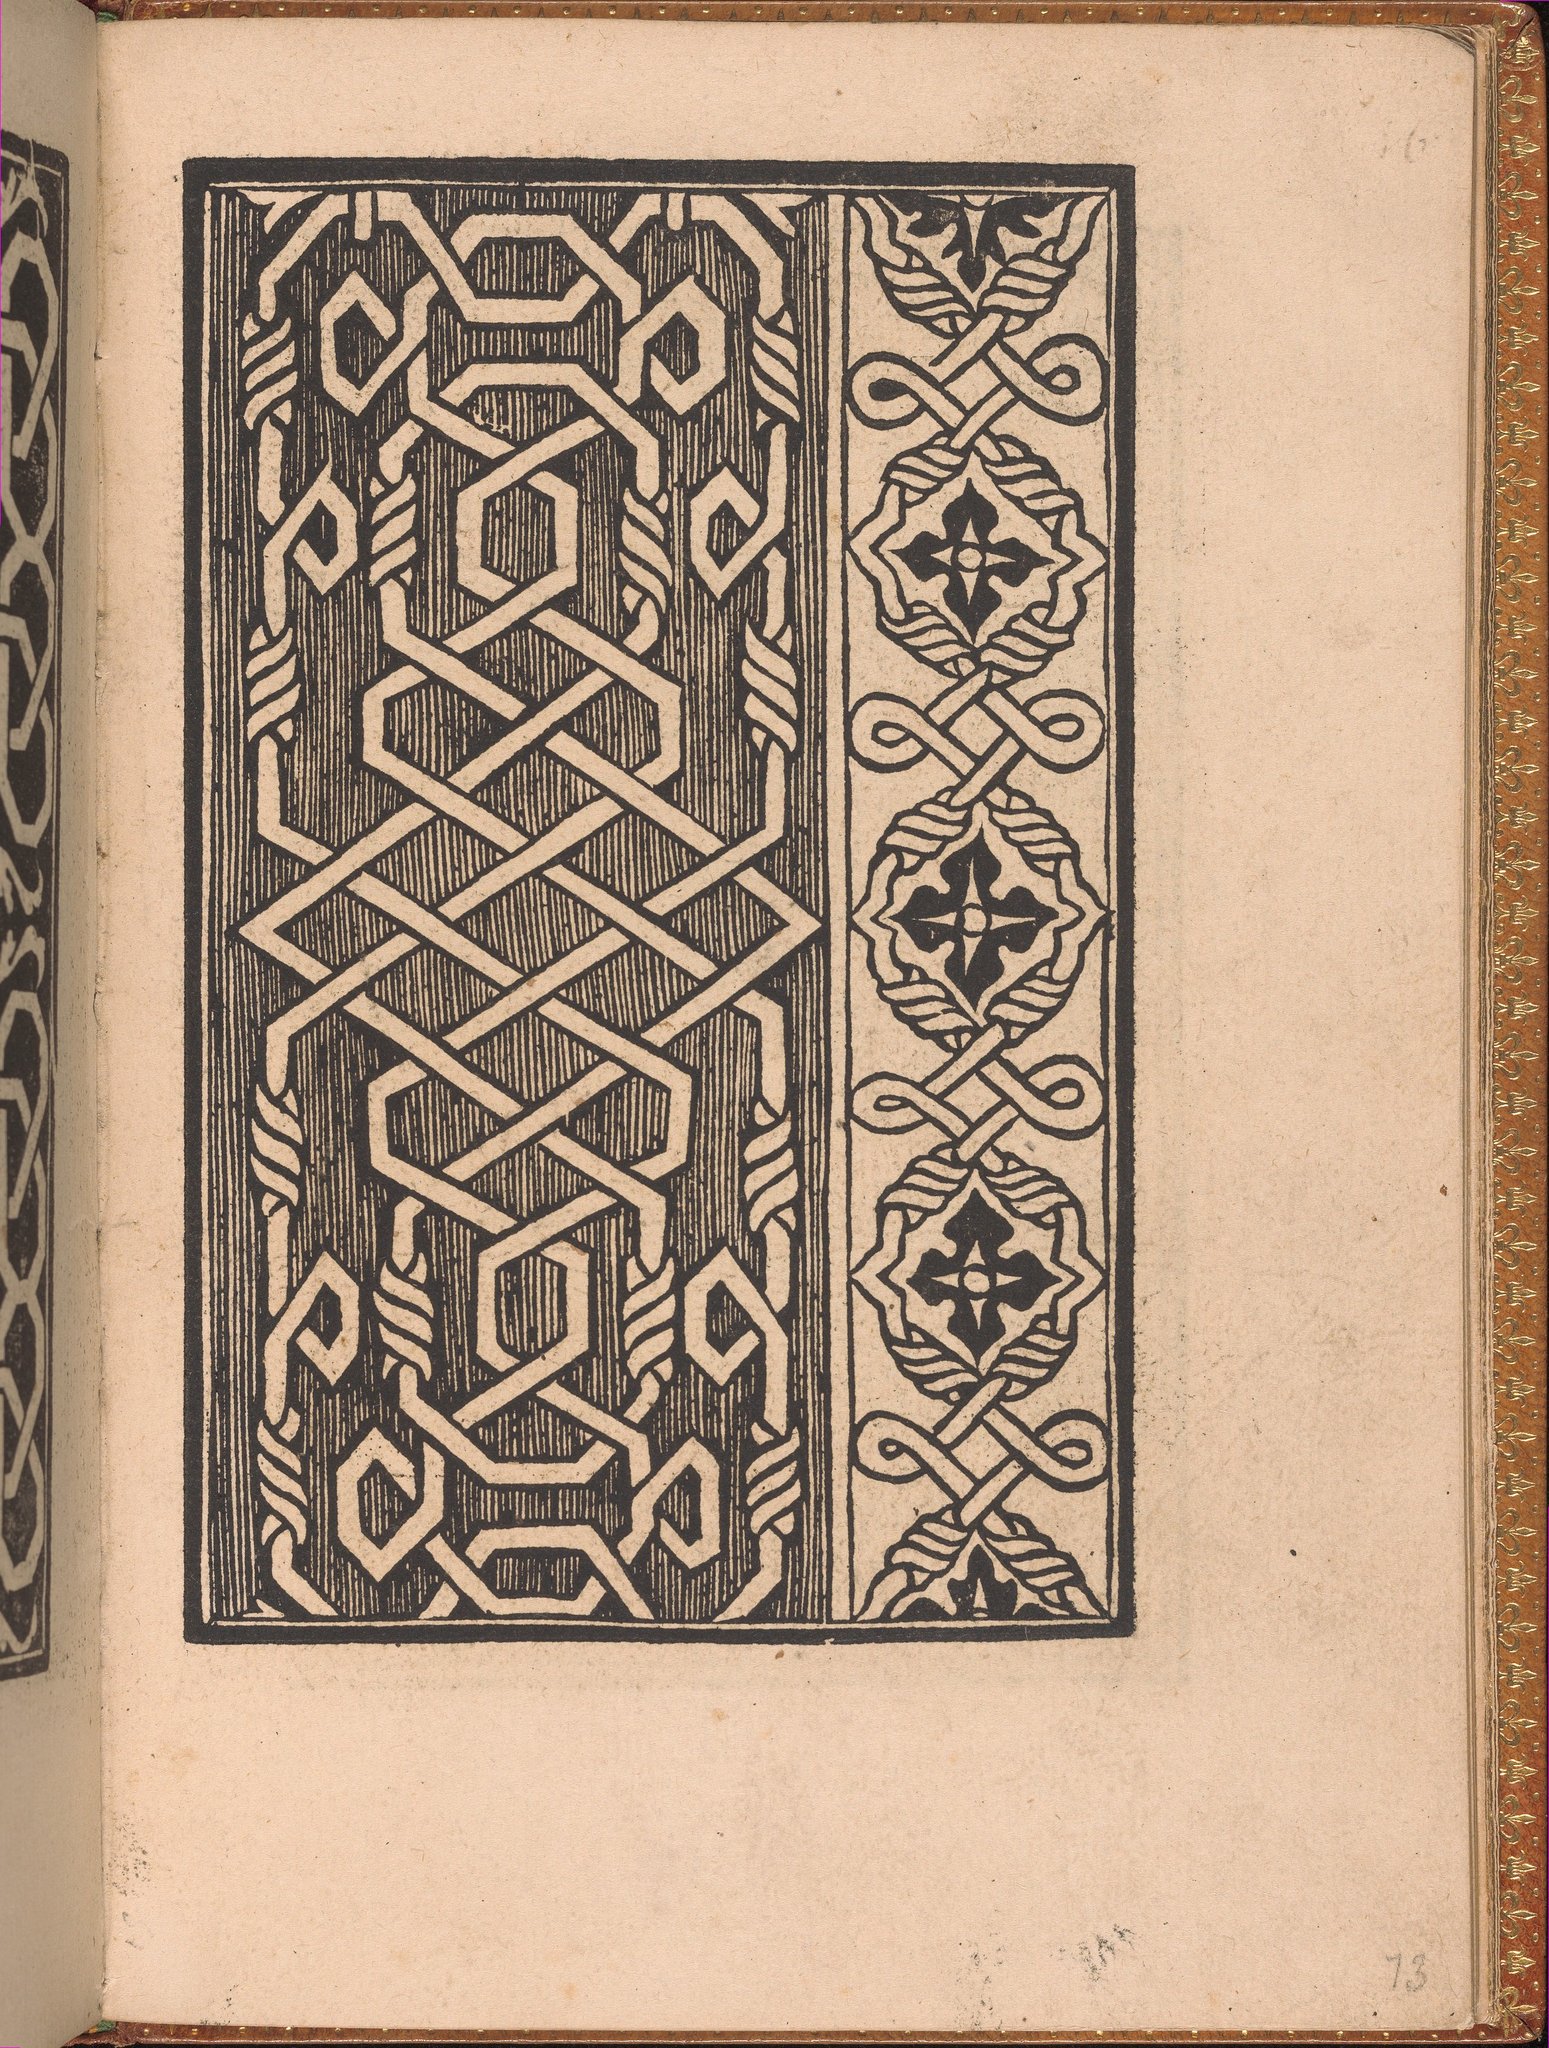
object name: book print ornament architecture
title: Convivio delle Belle Donne, page 13 (recto)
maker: nicolò zoppino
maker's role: publisher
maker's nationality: italian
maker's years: 1478-1544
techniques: woodcut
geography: italy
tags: ornament